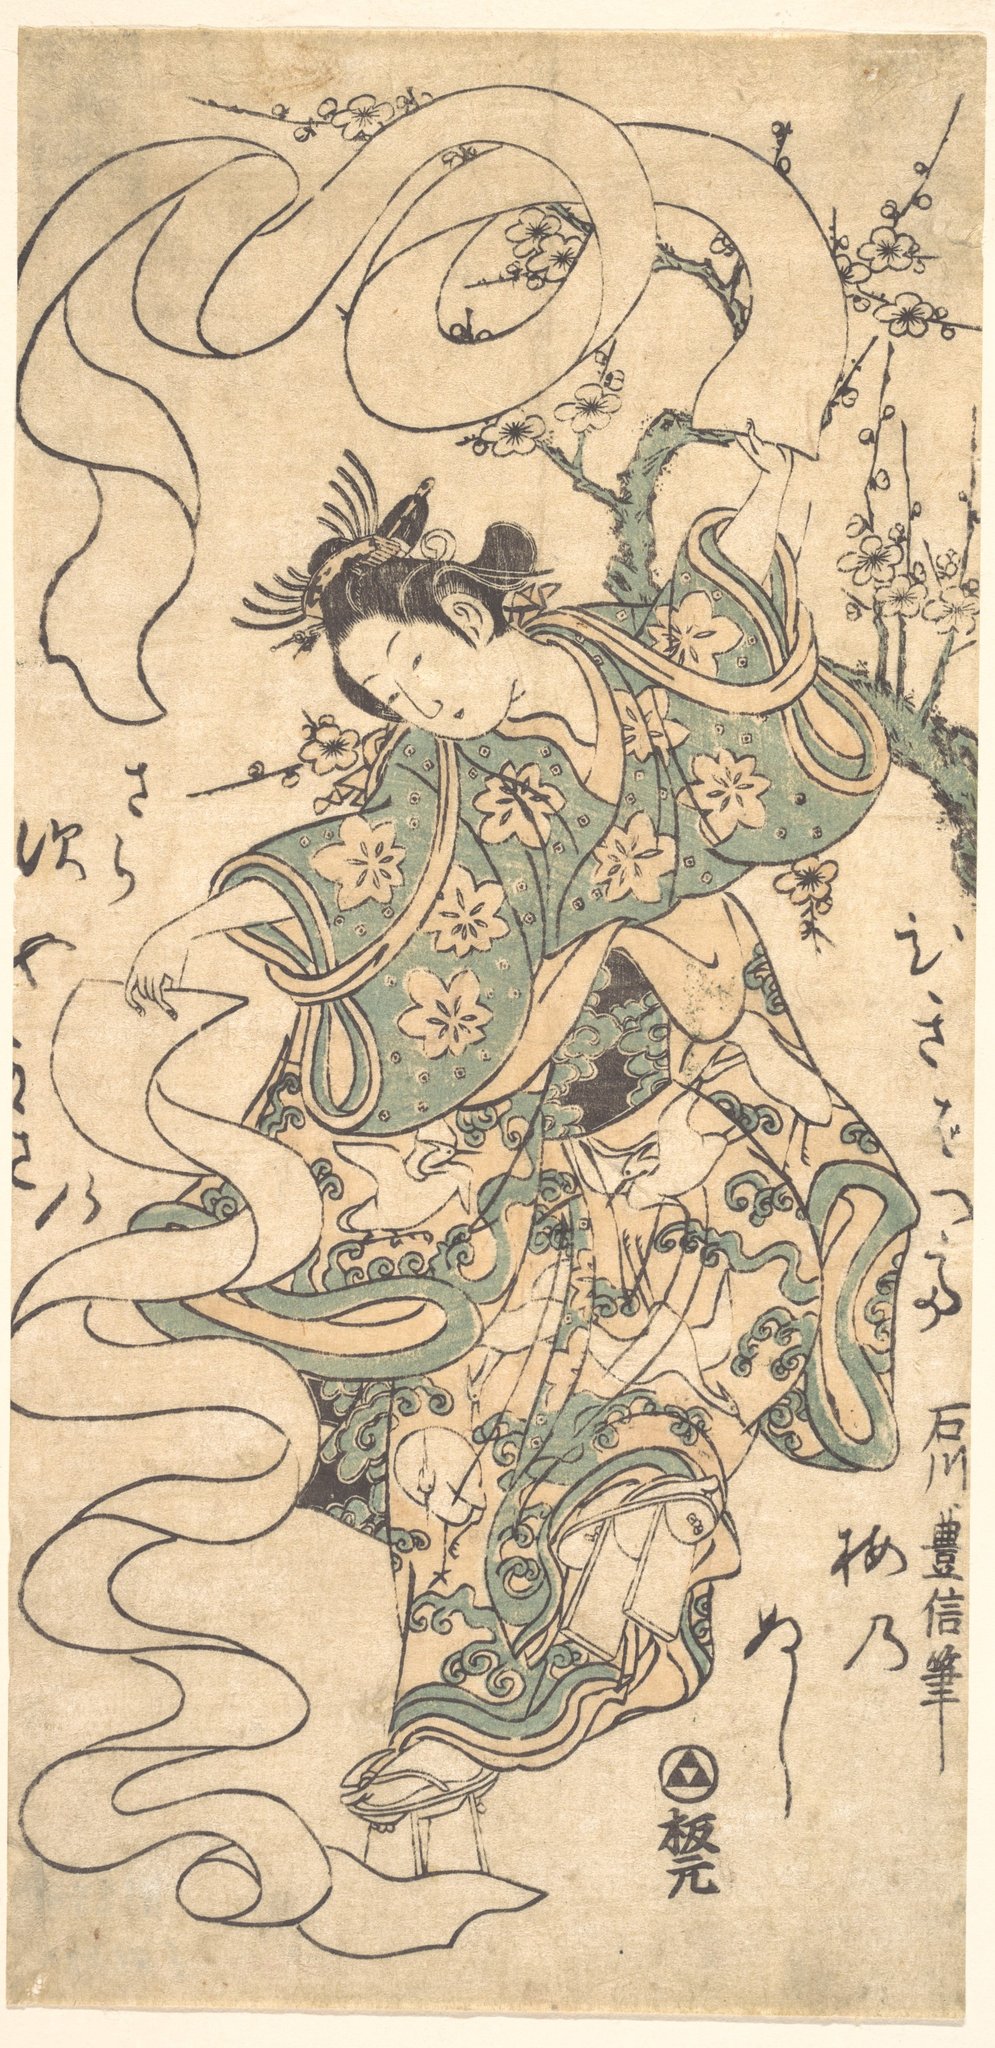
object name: print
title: The Dance of the Scarves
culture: japanese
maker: ishikawa toyonobu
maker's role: artist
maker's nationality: japanese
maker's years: 1711-1785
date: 1711-1785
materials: ink, paper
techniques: woodblock print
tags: dance,women